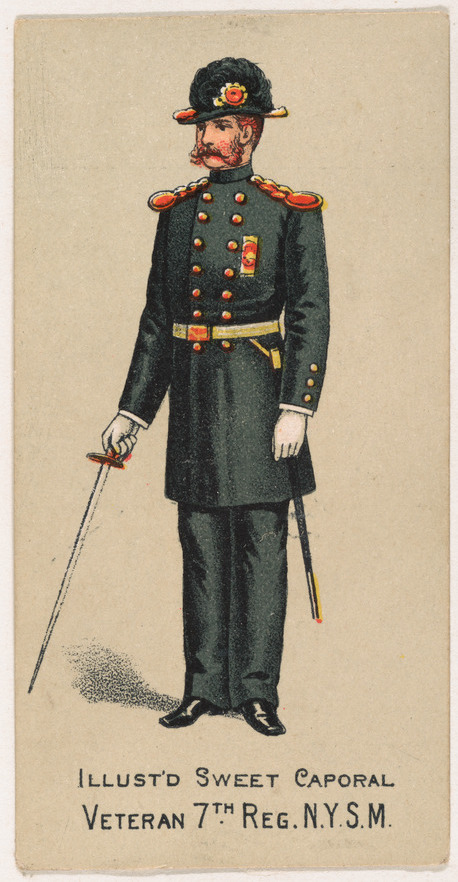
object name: print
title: Veteran, 7th Regiment, New York State Militia, from the Military Series (N224) issued by Kinney Tobacco Company to promote Sweet Caporal Cigarettes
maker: kinney brothers tobacco company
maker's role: publisher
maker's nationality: american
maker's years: 1869-2011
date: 1888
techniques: color lithograph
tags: military,swords,men